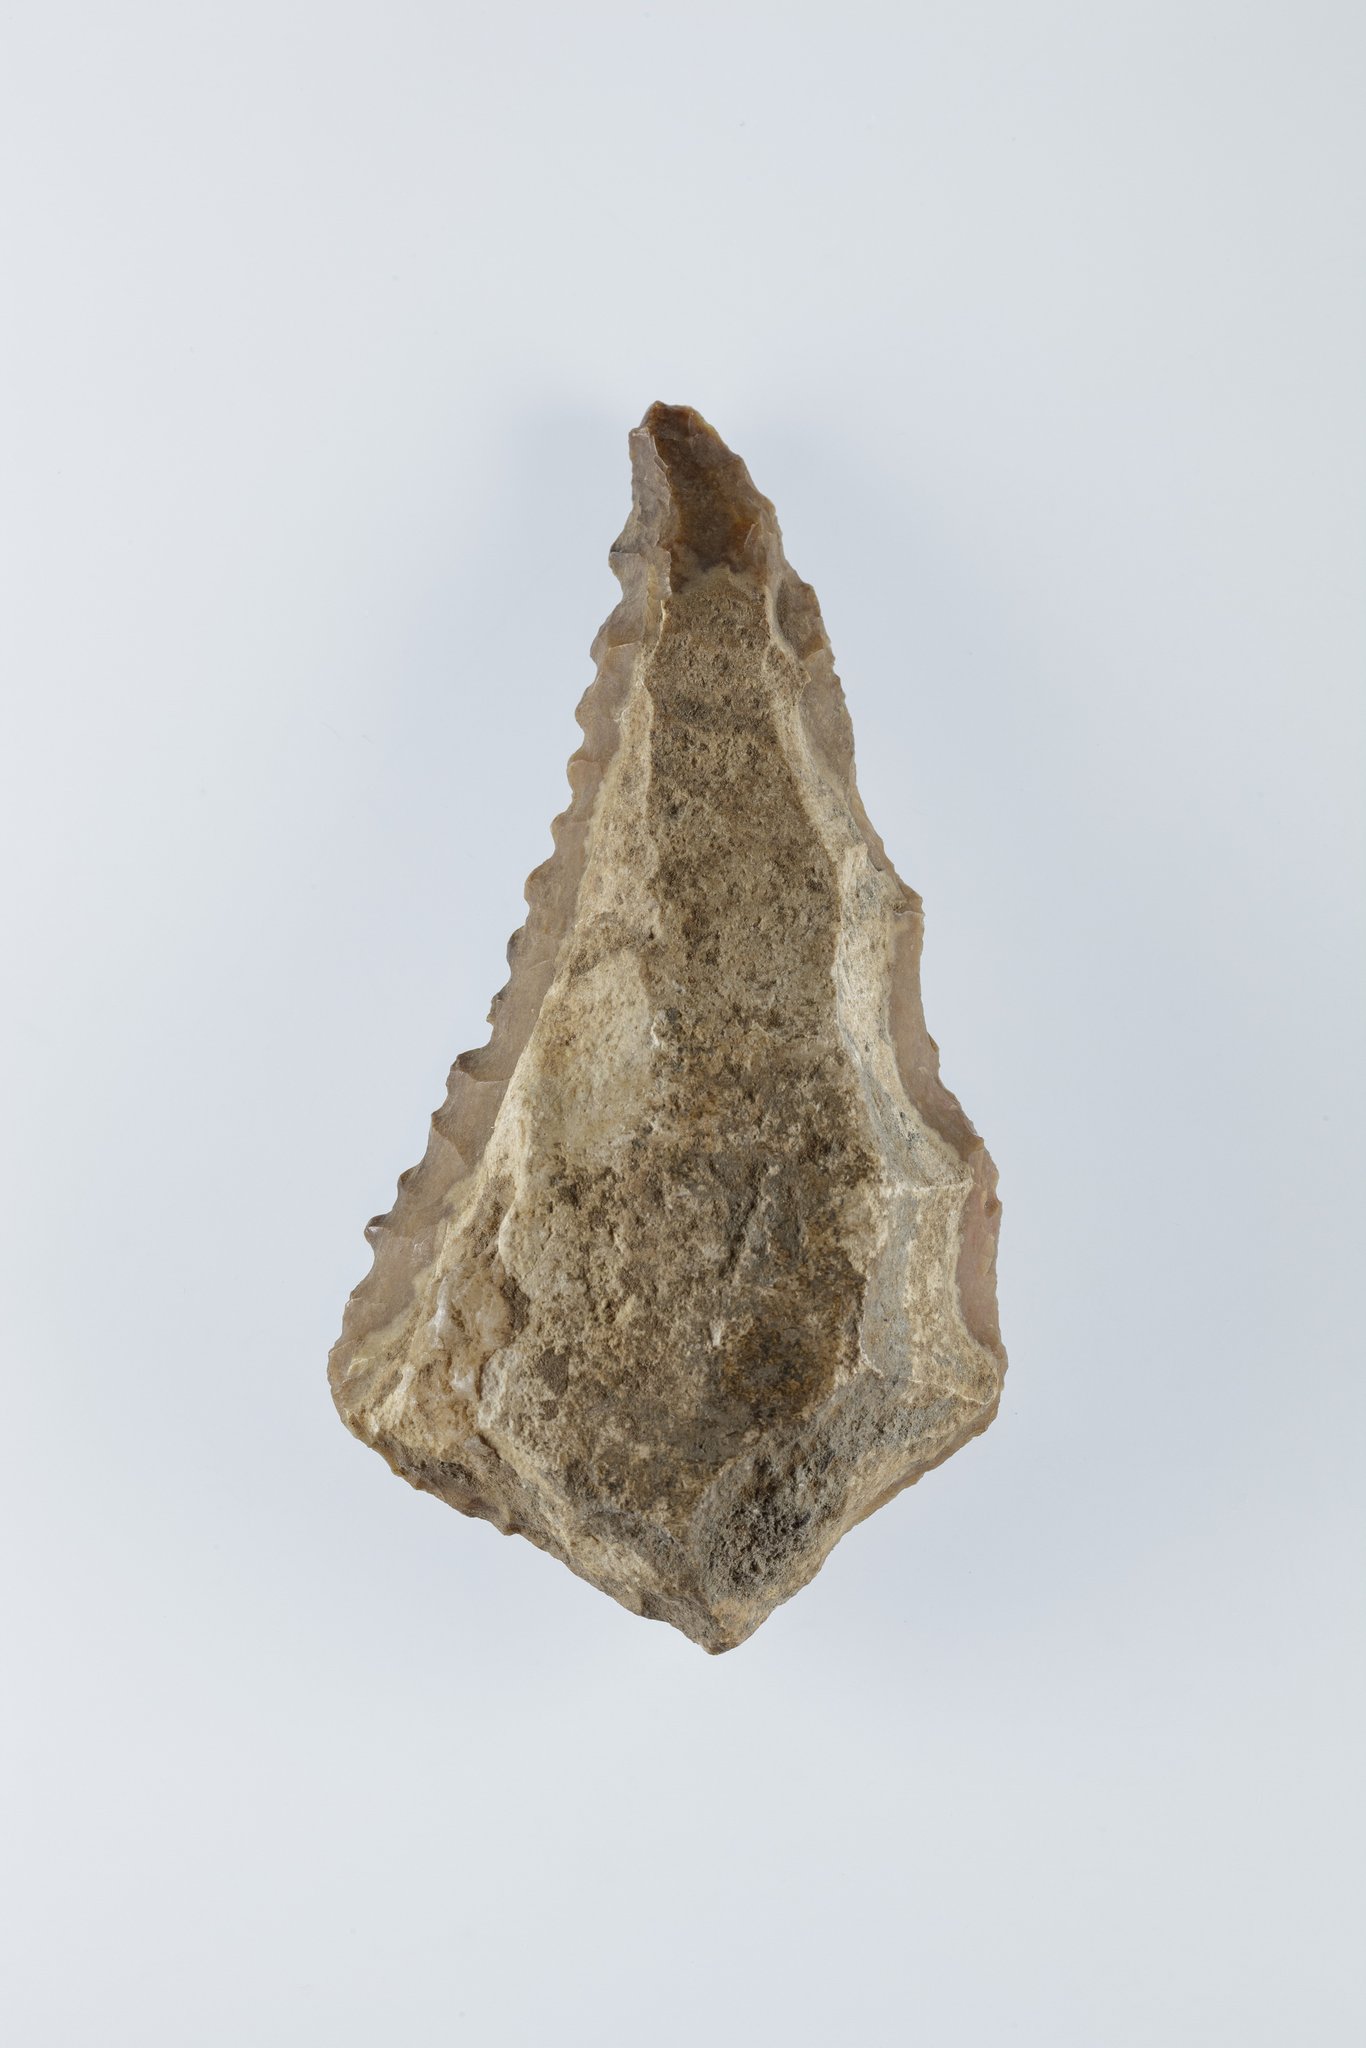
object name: sickle, denticulate, truncated, backed, geometric, tool, element, adhesive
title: Sickle Insert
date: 1186-1070 BCE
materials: stone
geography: egypt